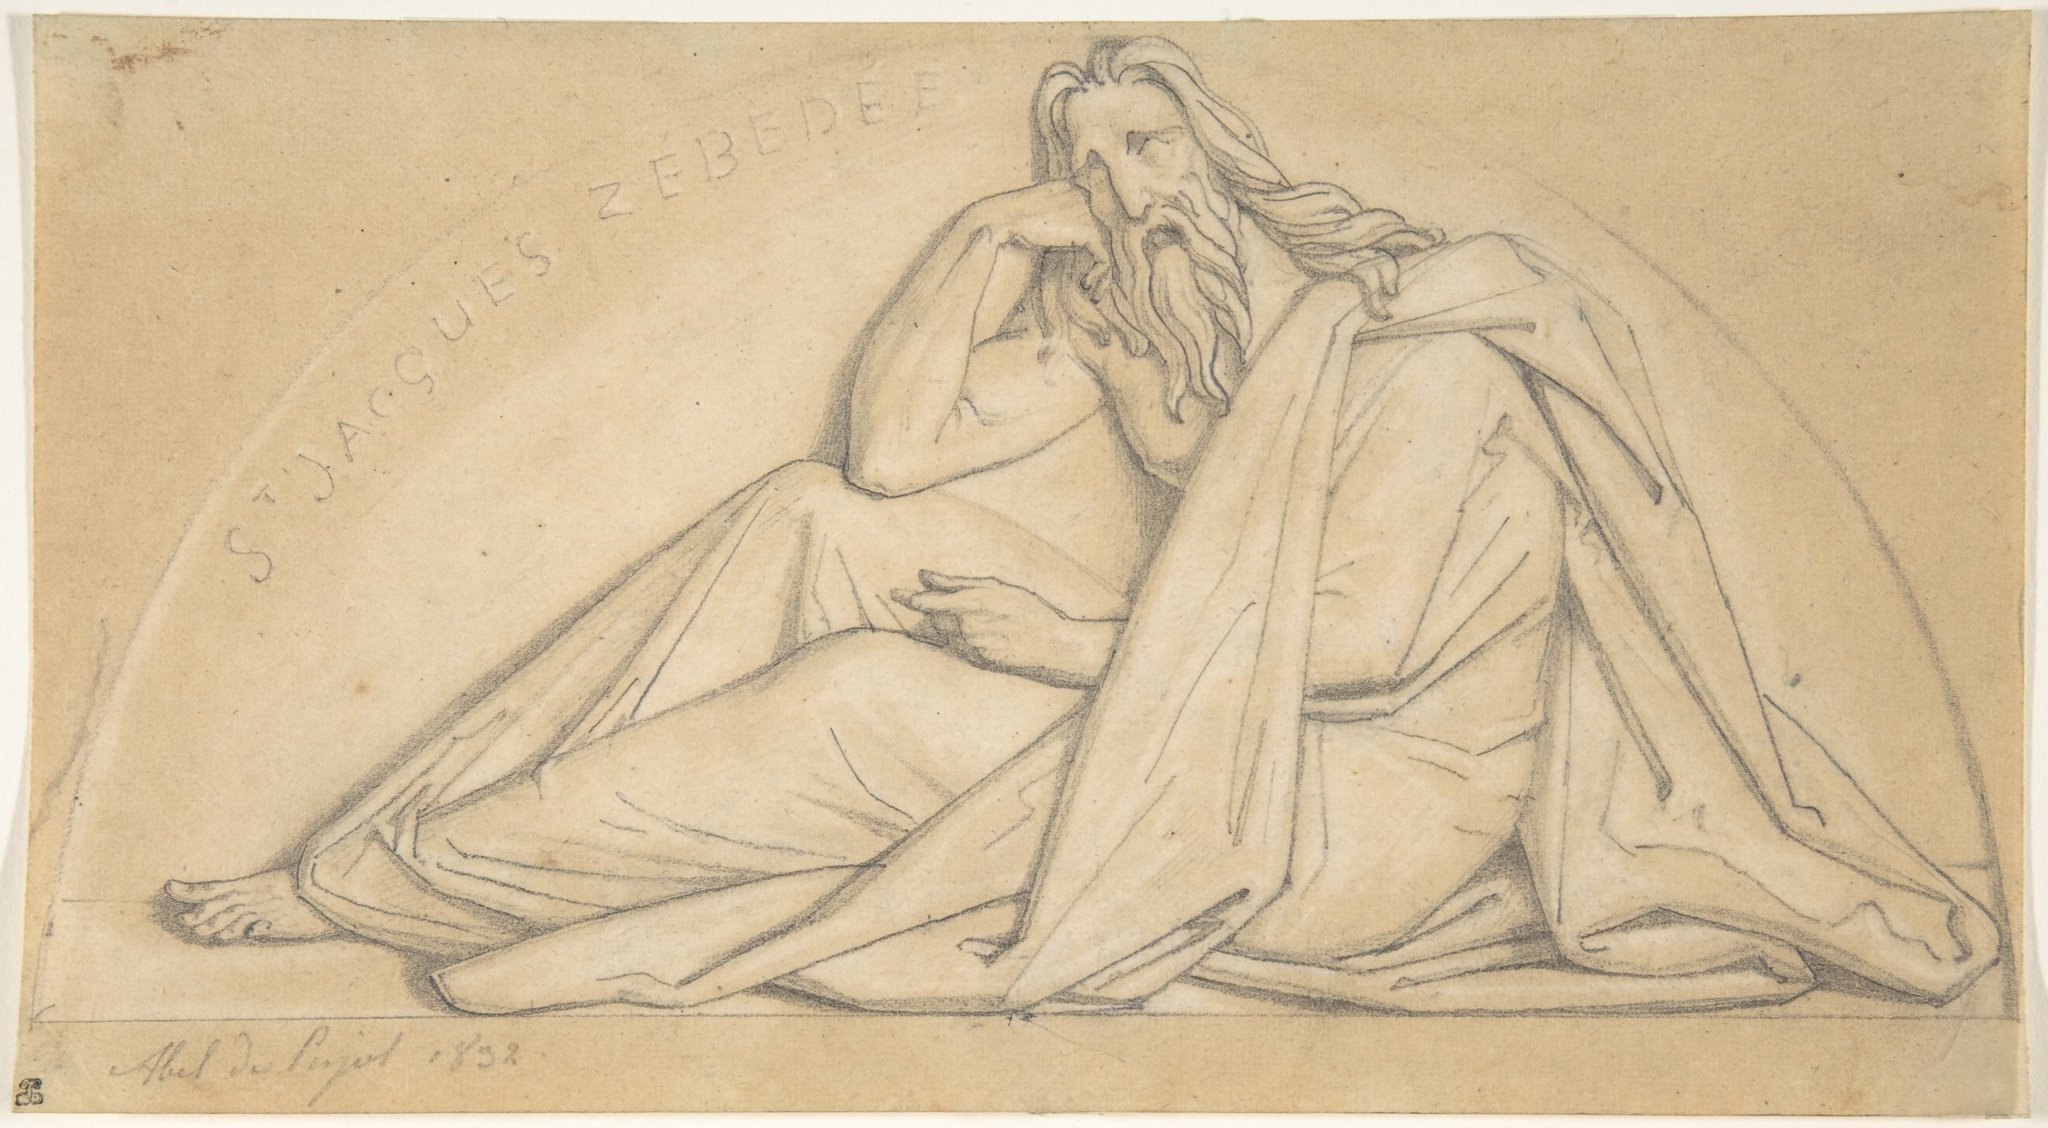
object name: drawing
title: John the Apostle, for the church of St. Vaast in Arras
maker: alexandre denis abel de pujol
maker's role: artist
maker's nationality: french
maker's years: 1785-1861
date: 1832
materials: graphite, paper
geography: france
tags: saints